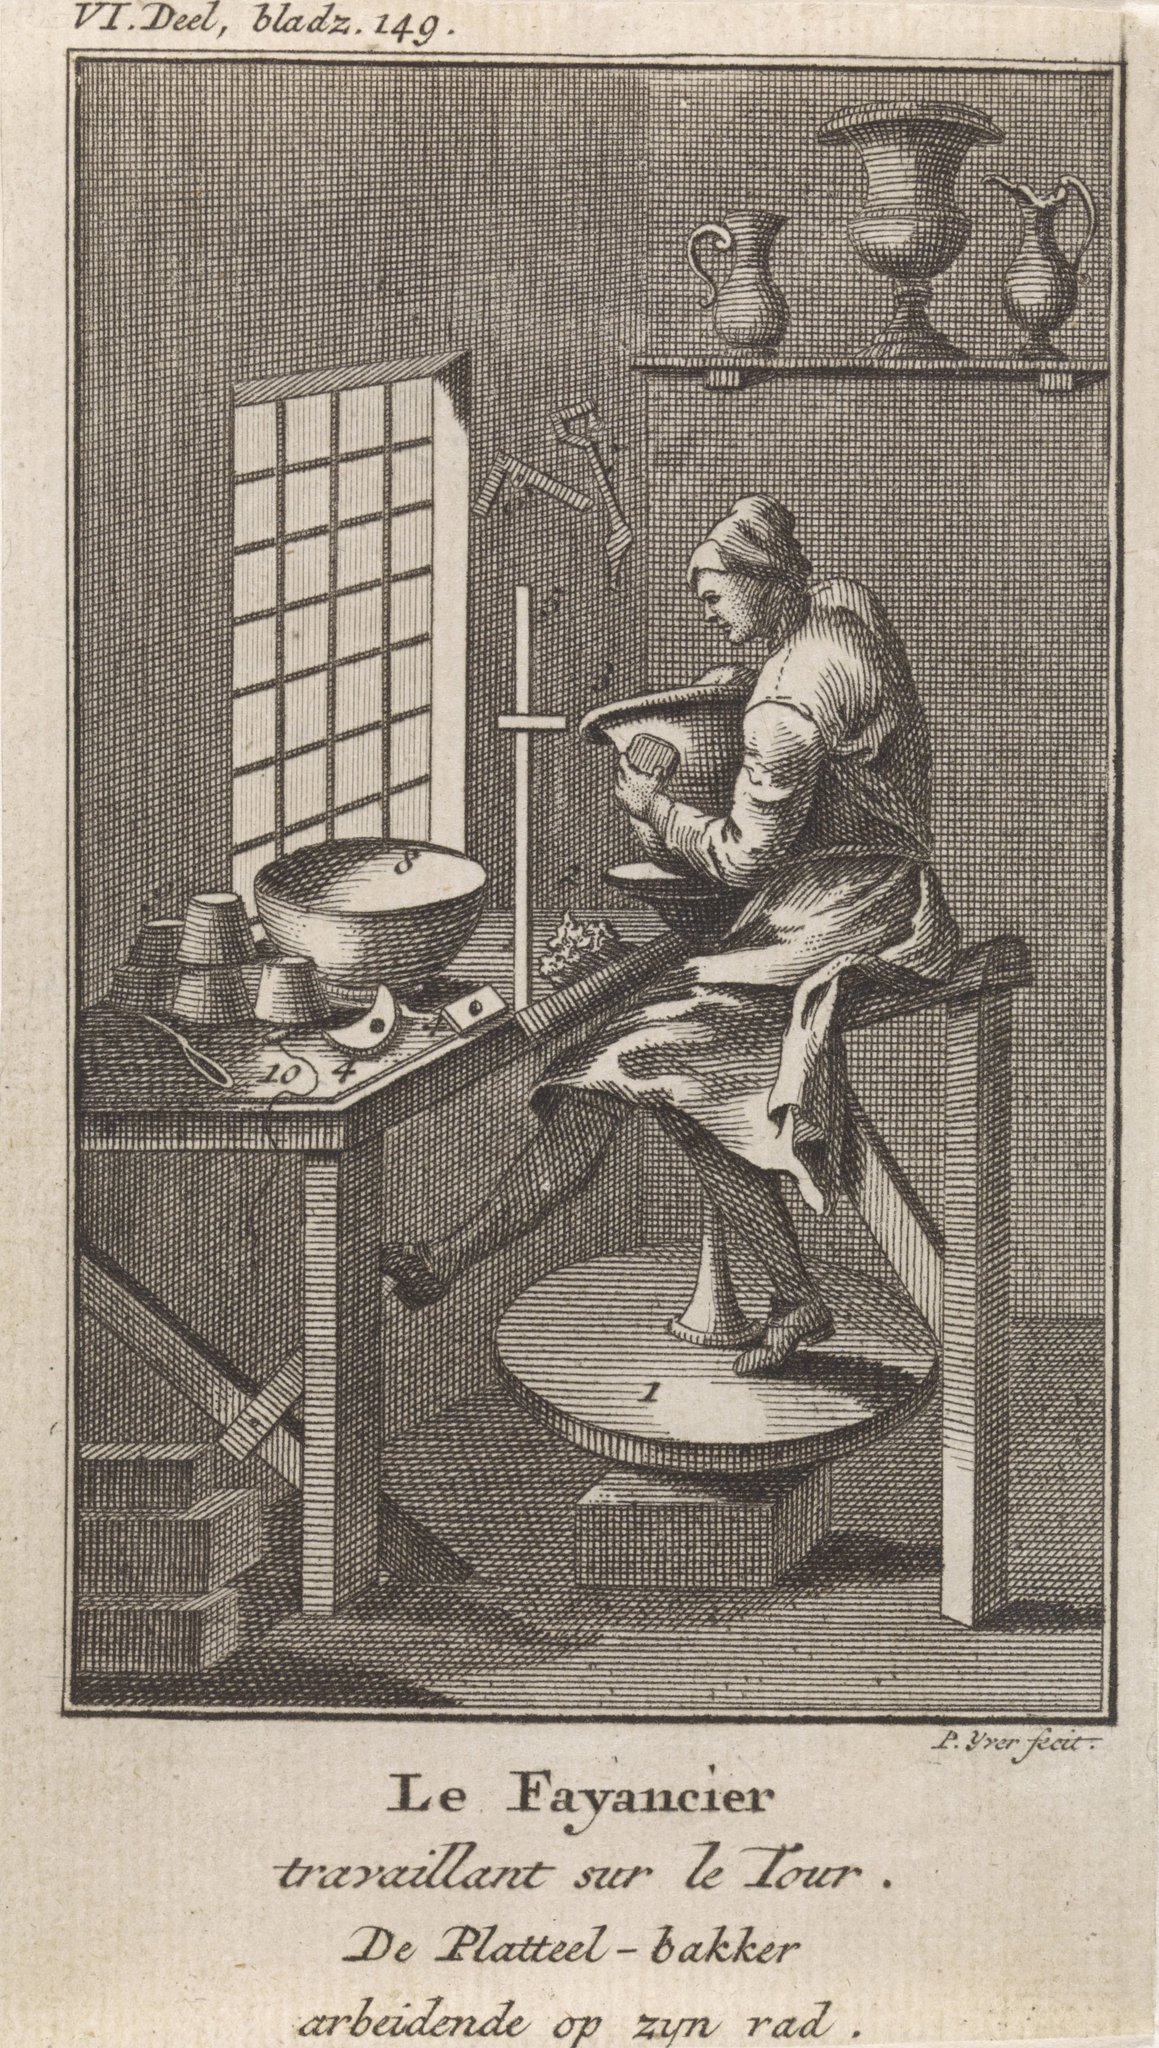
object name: book illustration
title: Plateelbakker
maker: pieter yver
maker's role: print maker, publisher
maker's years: 1712-1787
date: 1735-1739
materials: paper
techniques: etching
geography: amsterdam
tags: potter, ceramist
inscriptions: collector's mark: Lugt 2228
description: Prent uit een van de delen van: Pluche, Noël Antoine. Le spectacle de la nature, ou Entretiens sur les particularités de l'histoire naturelle. 4 dln. Den Haag: Jean Neaulme, 1735-1739.